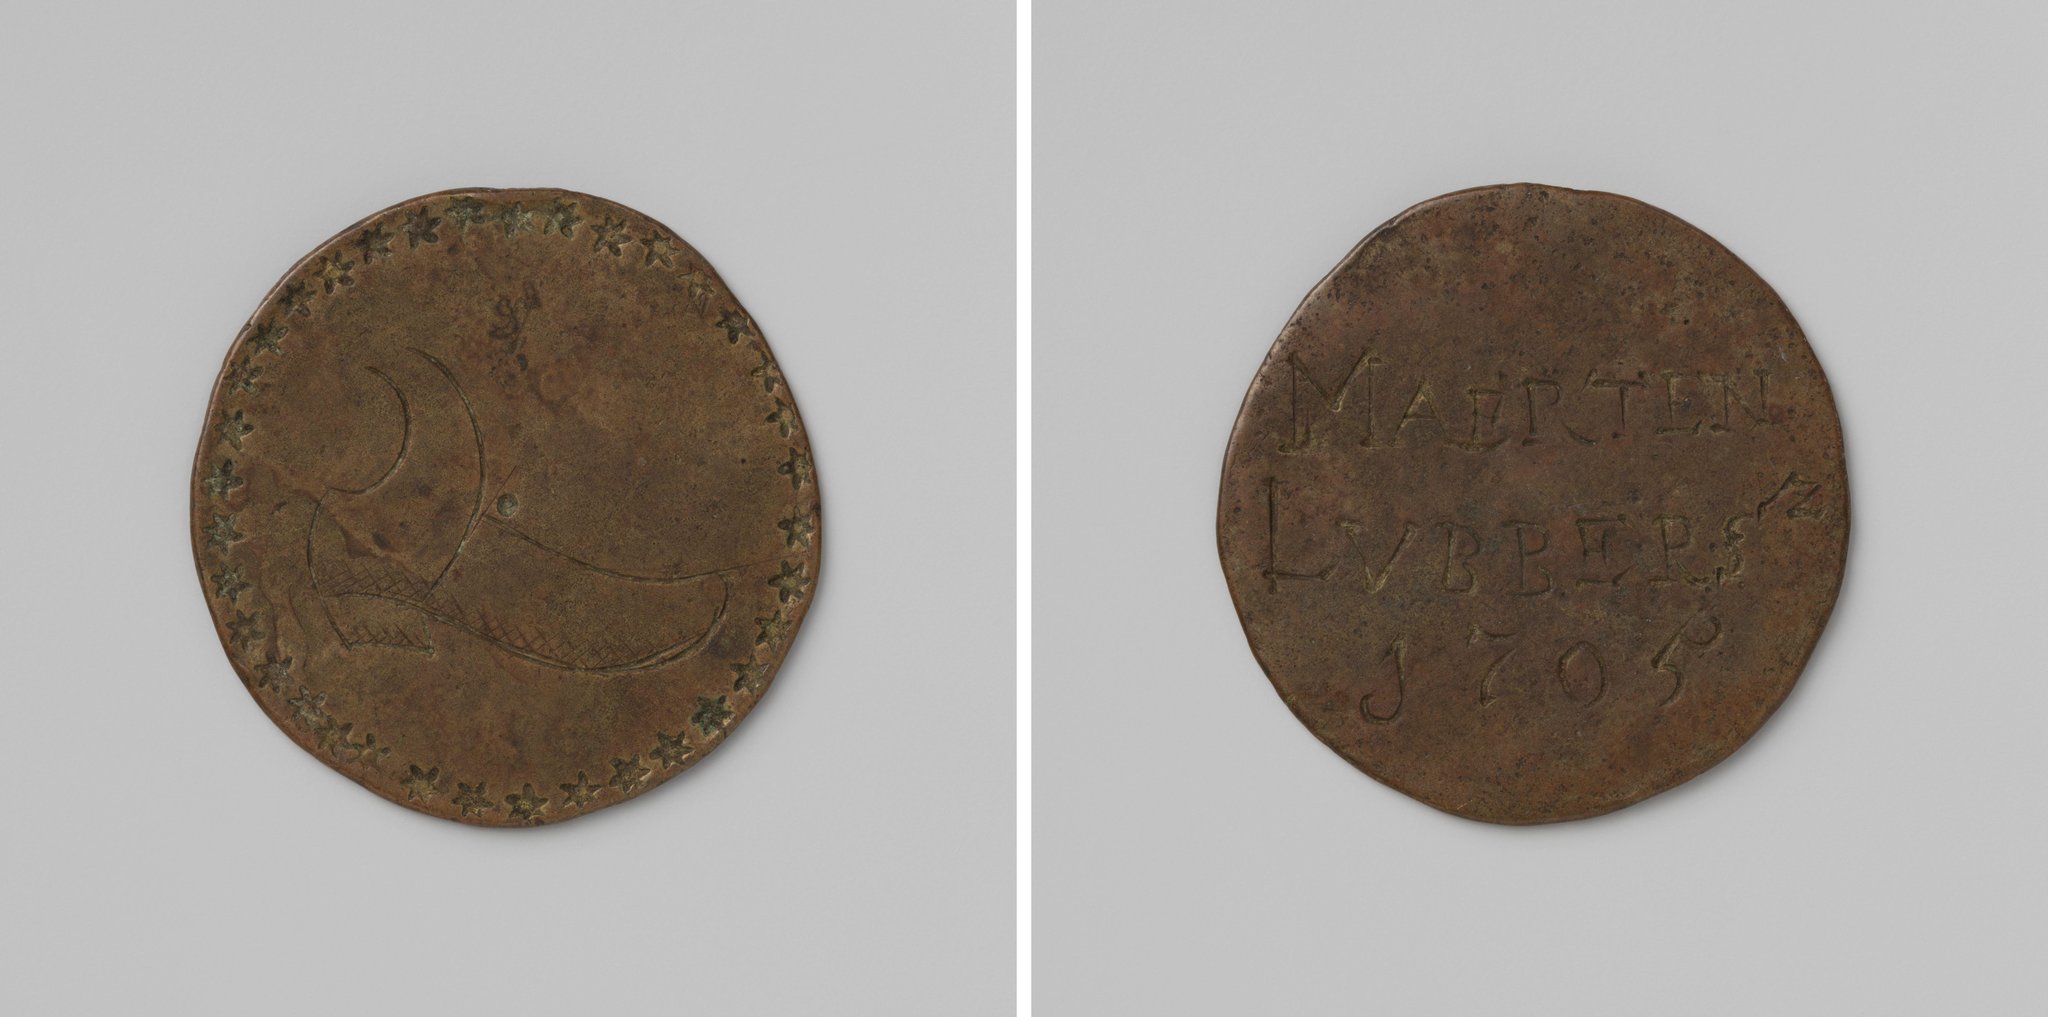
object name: medal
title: Schoenmakersgilde, gildepenning van Maerten Lubbersz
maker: Anonymous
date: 1705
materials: brass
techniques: engraving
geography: netherlands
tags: maerten lubbersz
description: Messing penning. Voorzijde: schoen binnen sterrenkrans. Keerzijde: opschrift en jaartal